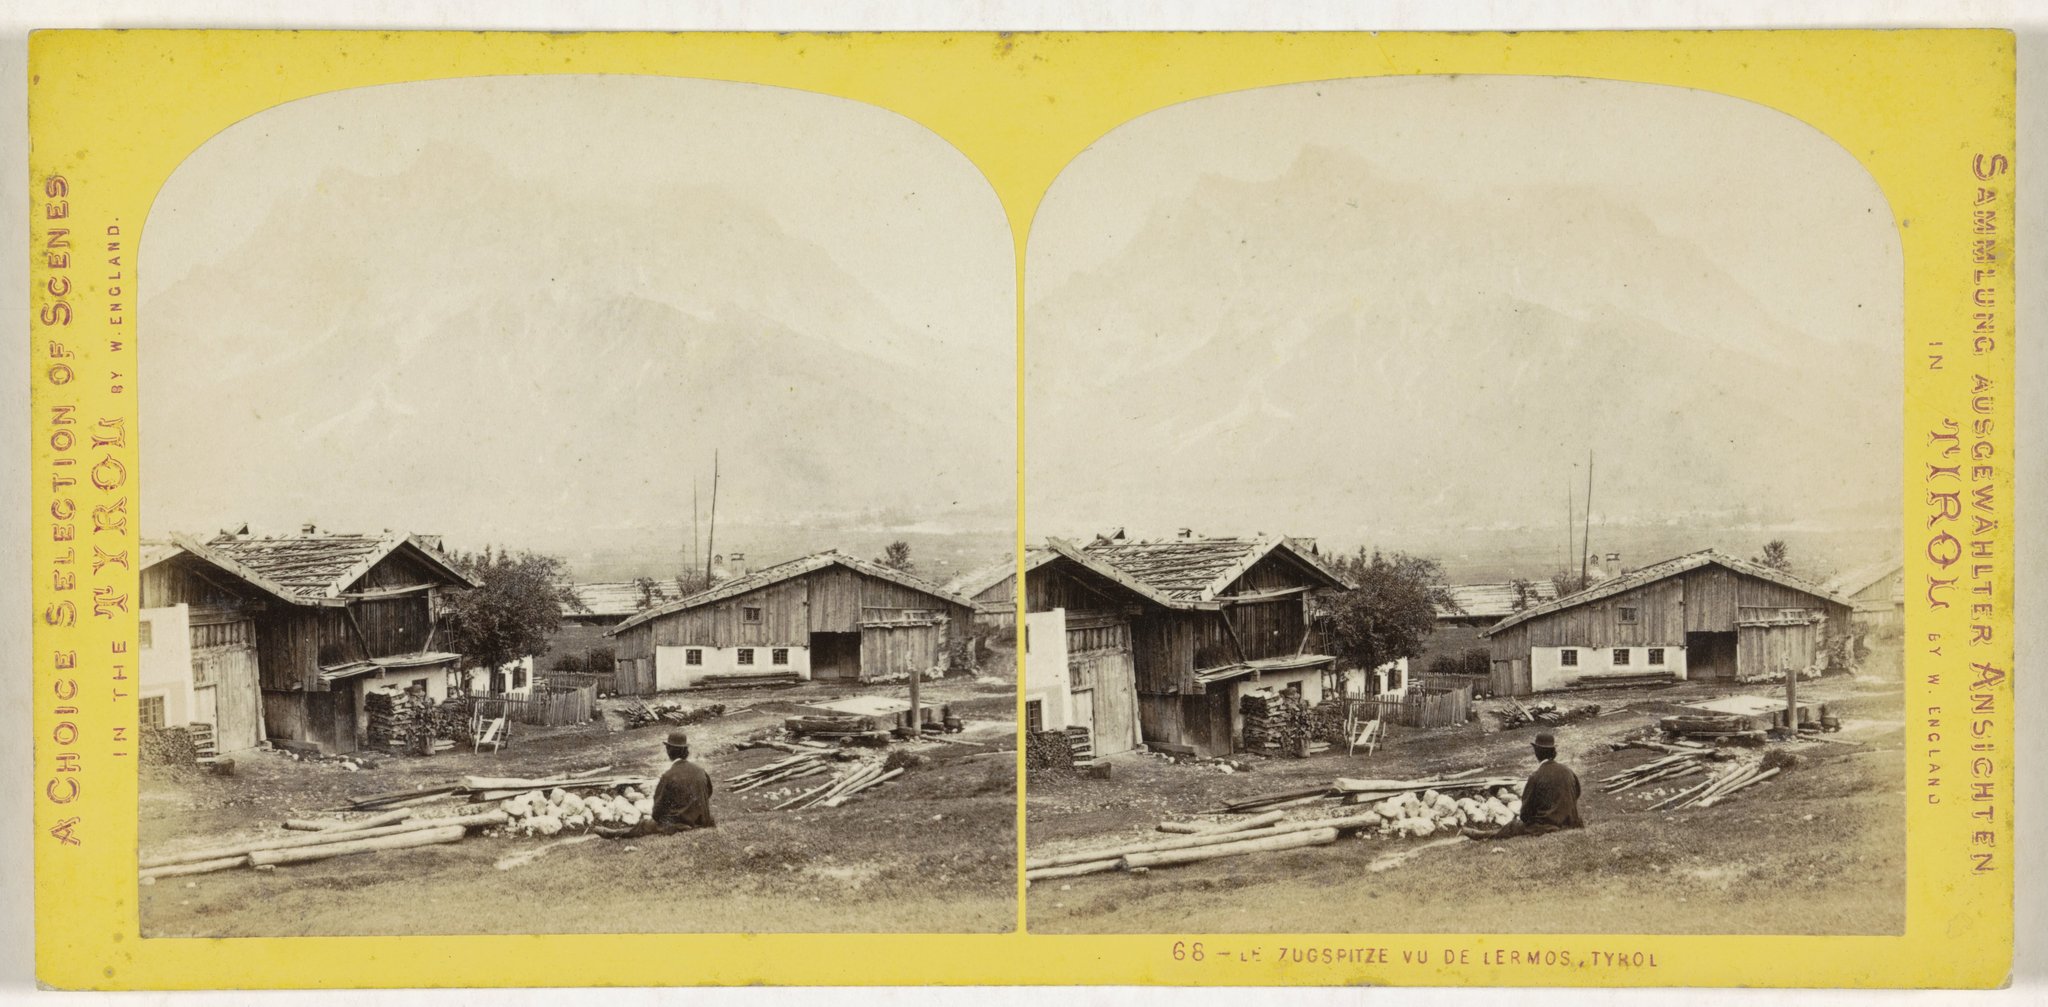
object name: stereograph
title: Zugspitze gezien vanaf Lermoos, Tirol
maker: william england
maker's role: fotograaf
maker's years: 1816-1896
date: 1863-1865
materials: cardboard, paper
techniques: albumen print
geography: lermoos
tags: village, mountains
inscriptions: number: ‘68’